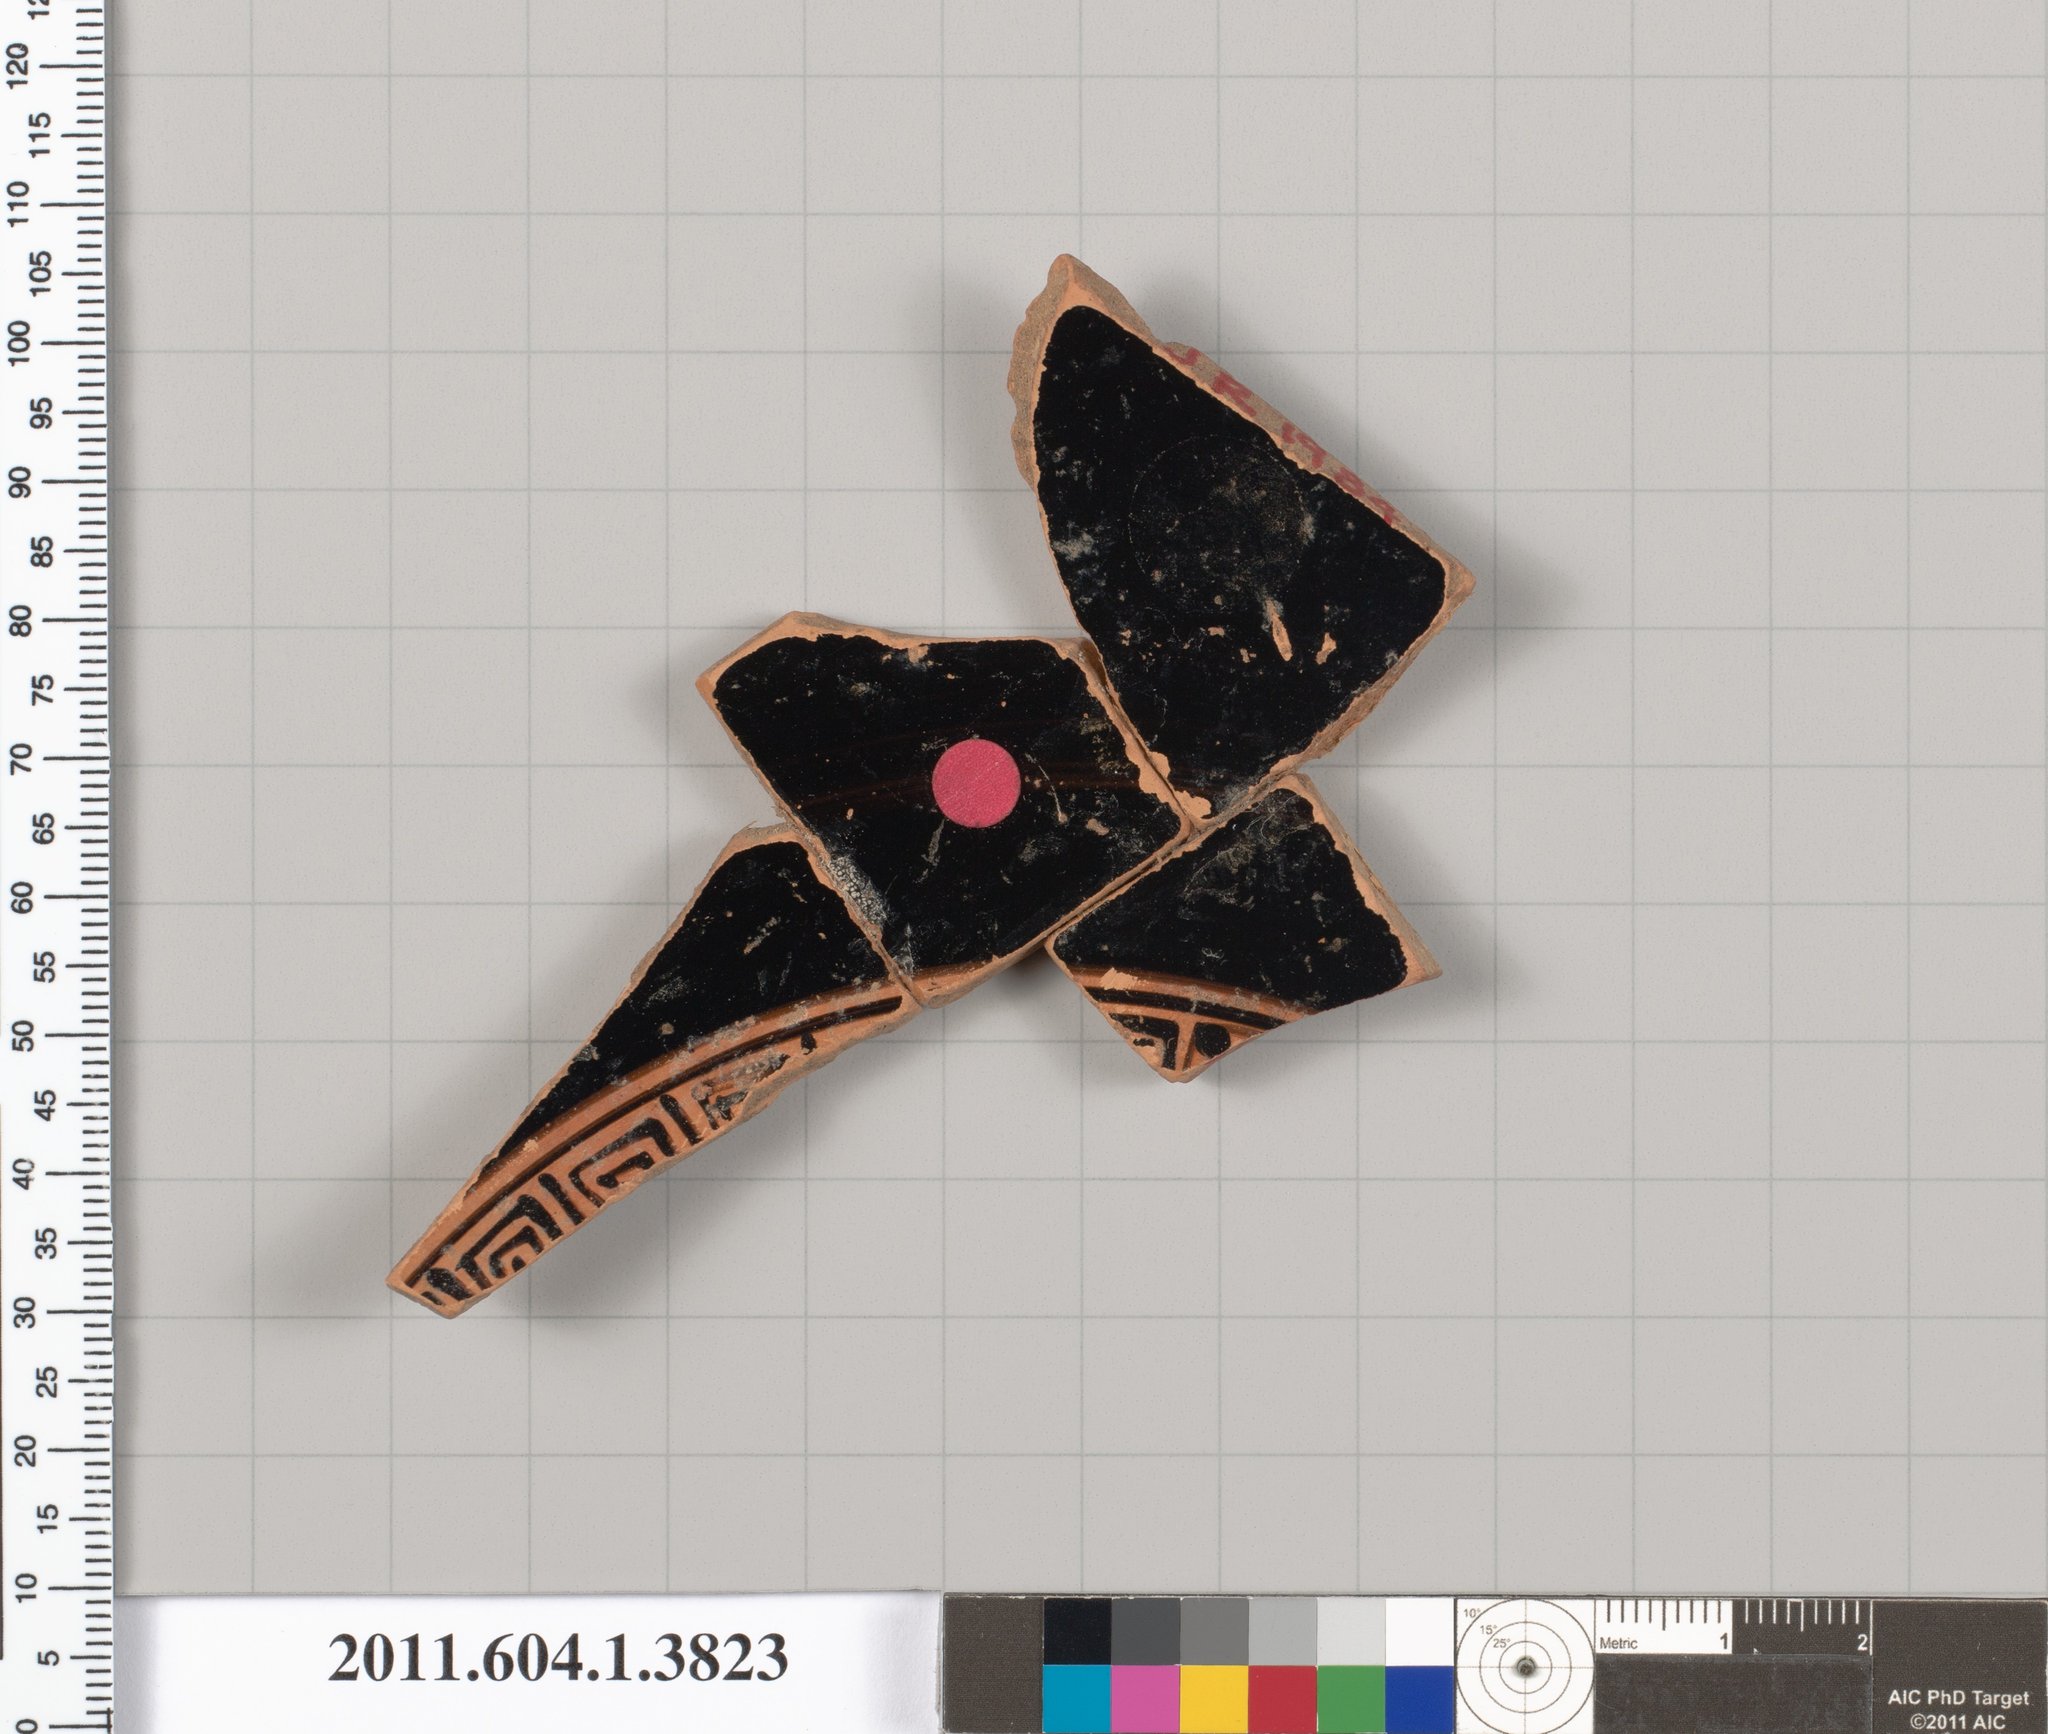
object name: kylix fragment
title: Terracotta fragment of a kylix (drinking cup)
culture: greek, attic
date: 475-451 BCE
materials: terracotta